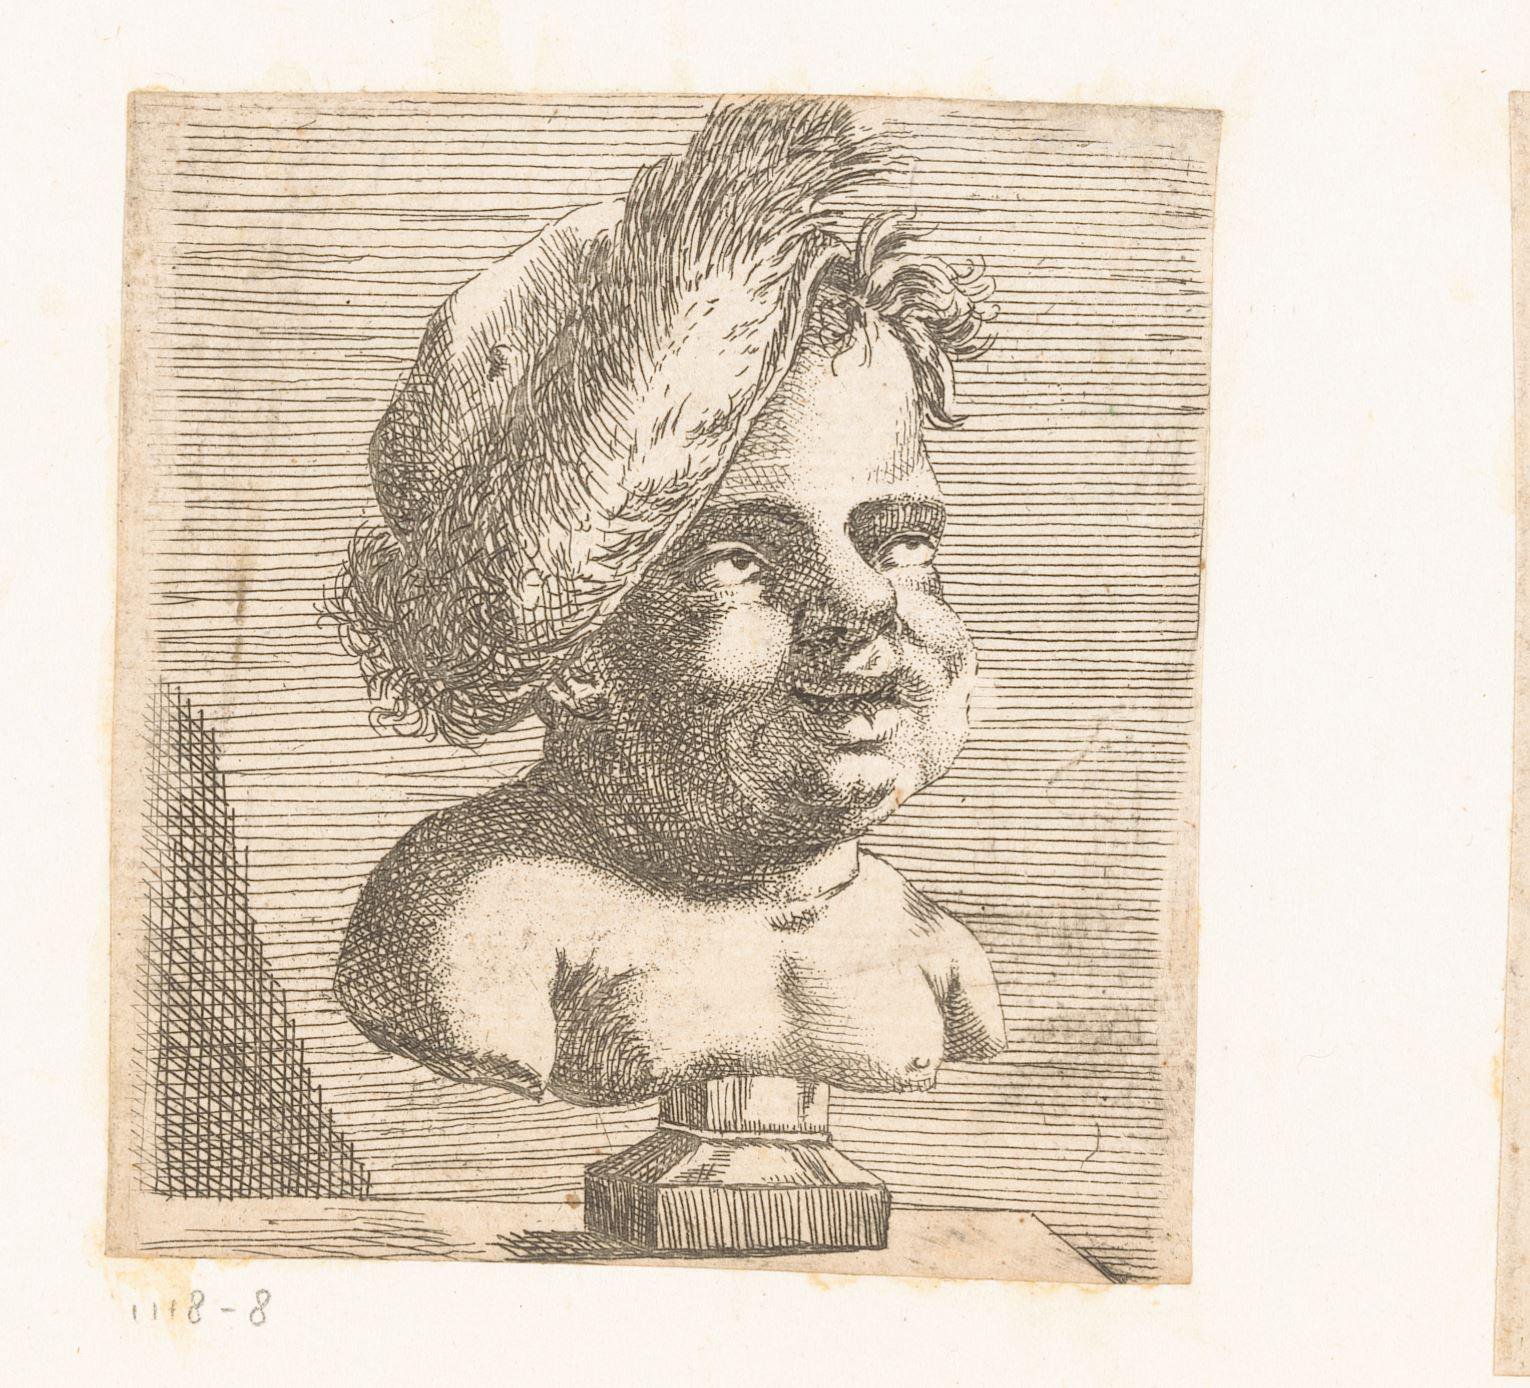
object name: print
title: Herm met kinderkop met baret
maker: françois bourlier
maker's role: draughtsman, painter, print maker, publisher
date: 1660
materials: paper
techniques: etching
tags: herms (garden ornaments), ornament ~ human parts, child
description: Herm met het hoofd van een kind met een baret. Onderdeel van een groep van negen bladen van zes verschillende kopjes.